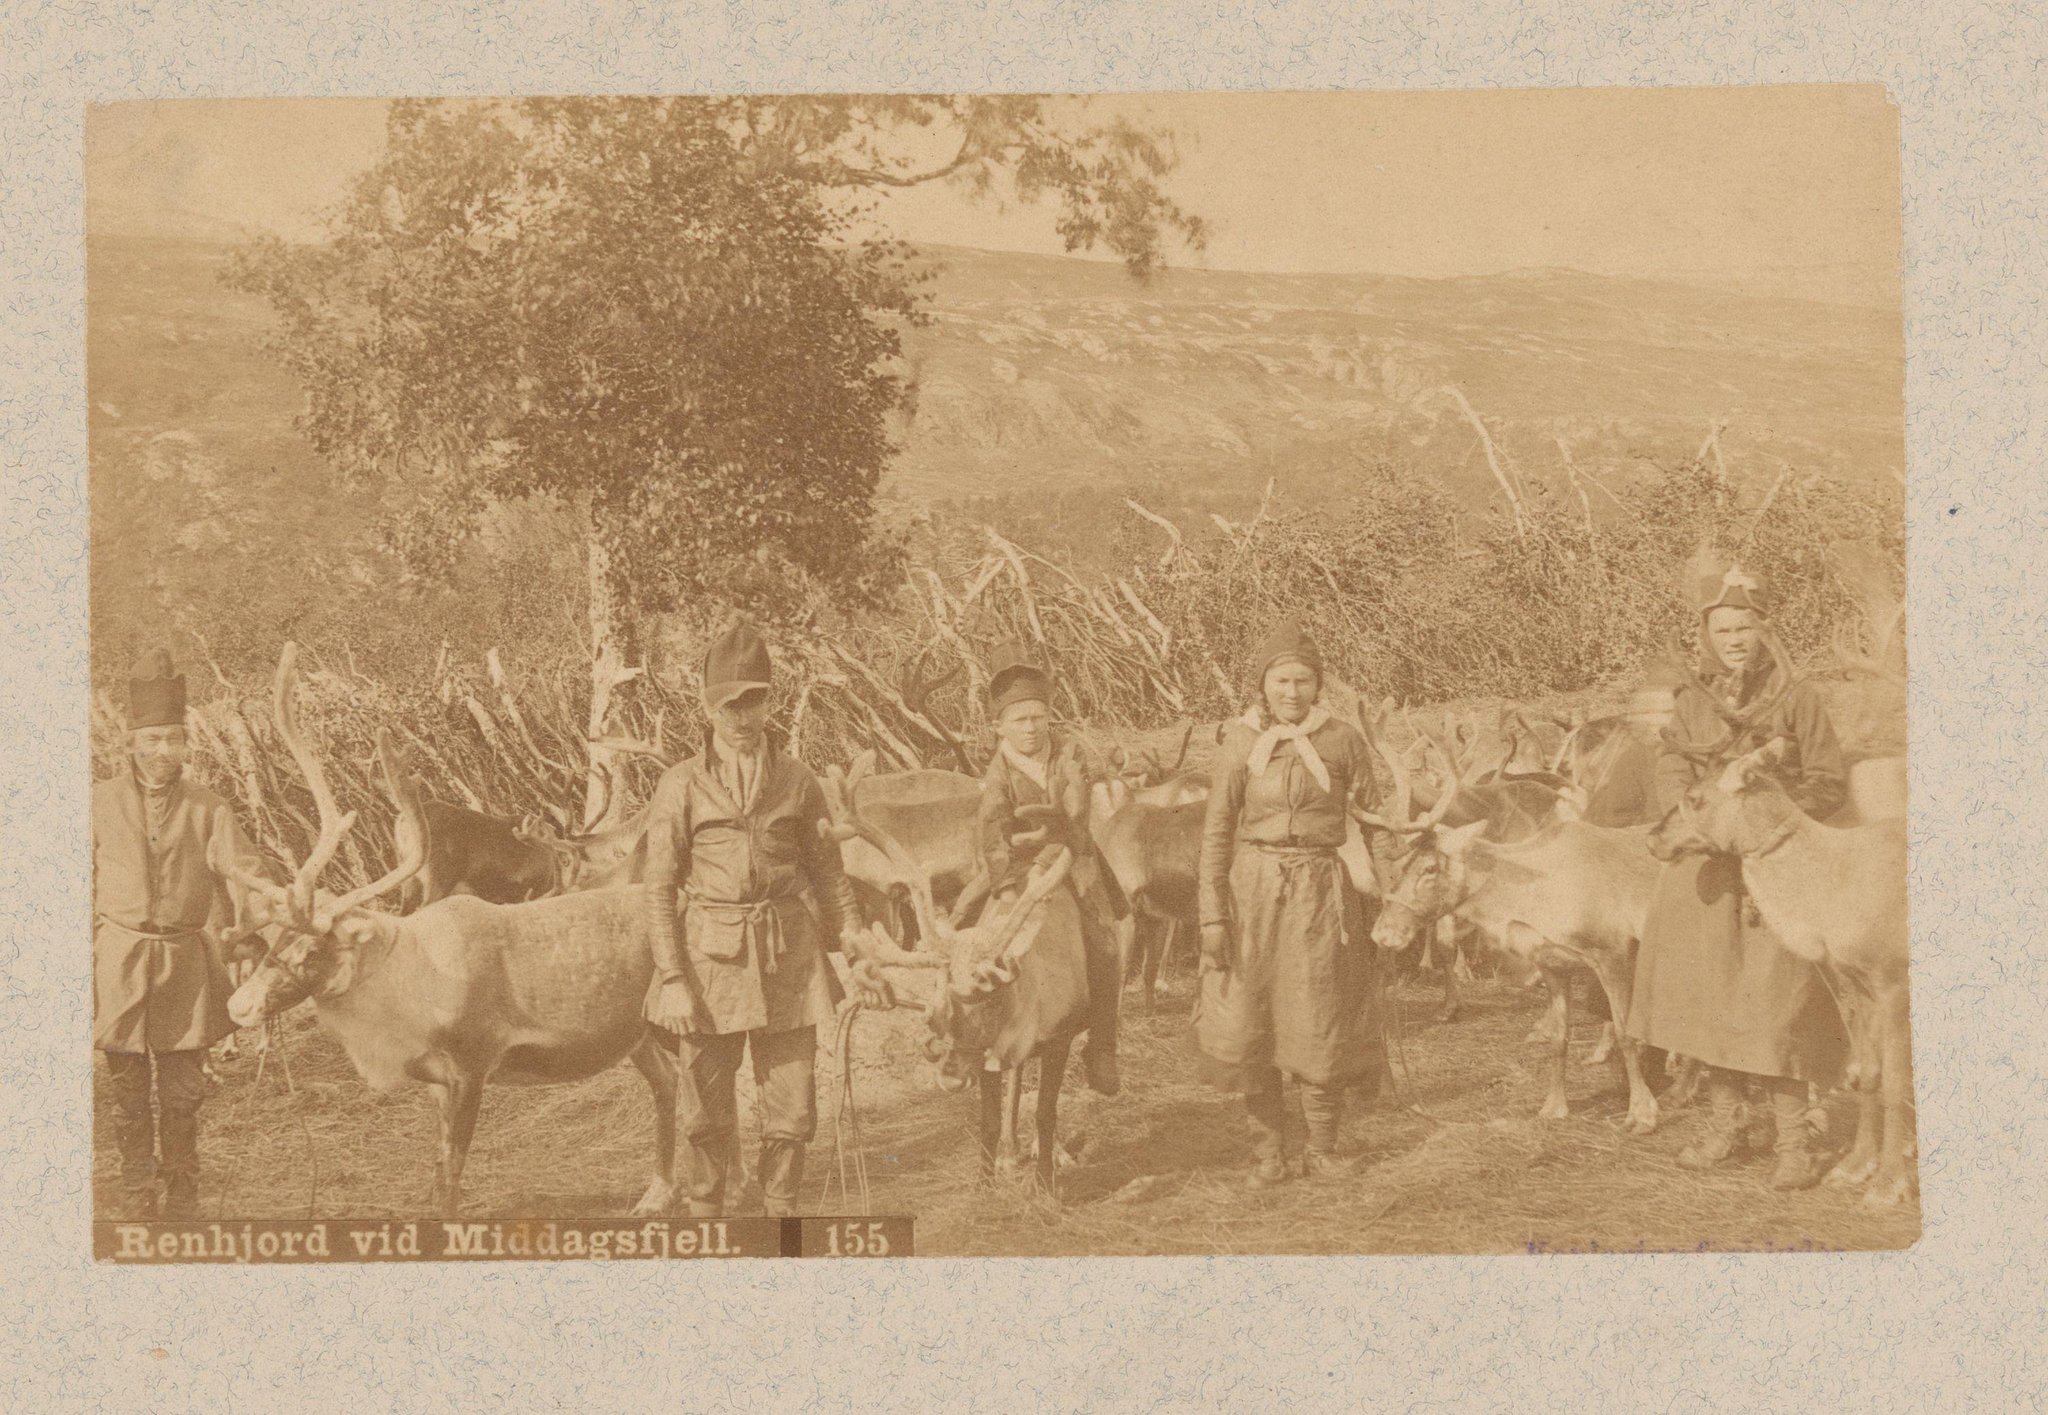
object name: photograph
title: Renhjord vid Middagsfjell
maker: Anonymous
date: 1860-1890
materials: cardboard, paper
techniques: albumen print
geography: middagsfjell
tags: hoofed animals: deer, anonymous historical persons portrayed in a group, in a group-portrait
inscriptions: number: ‘155’